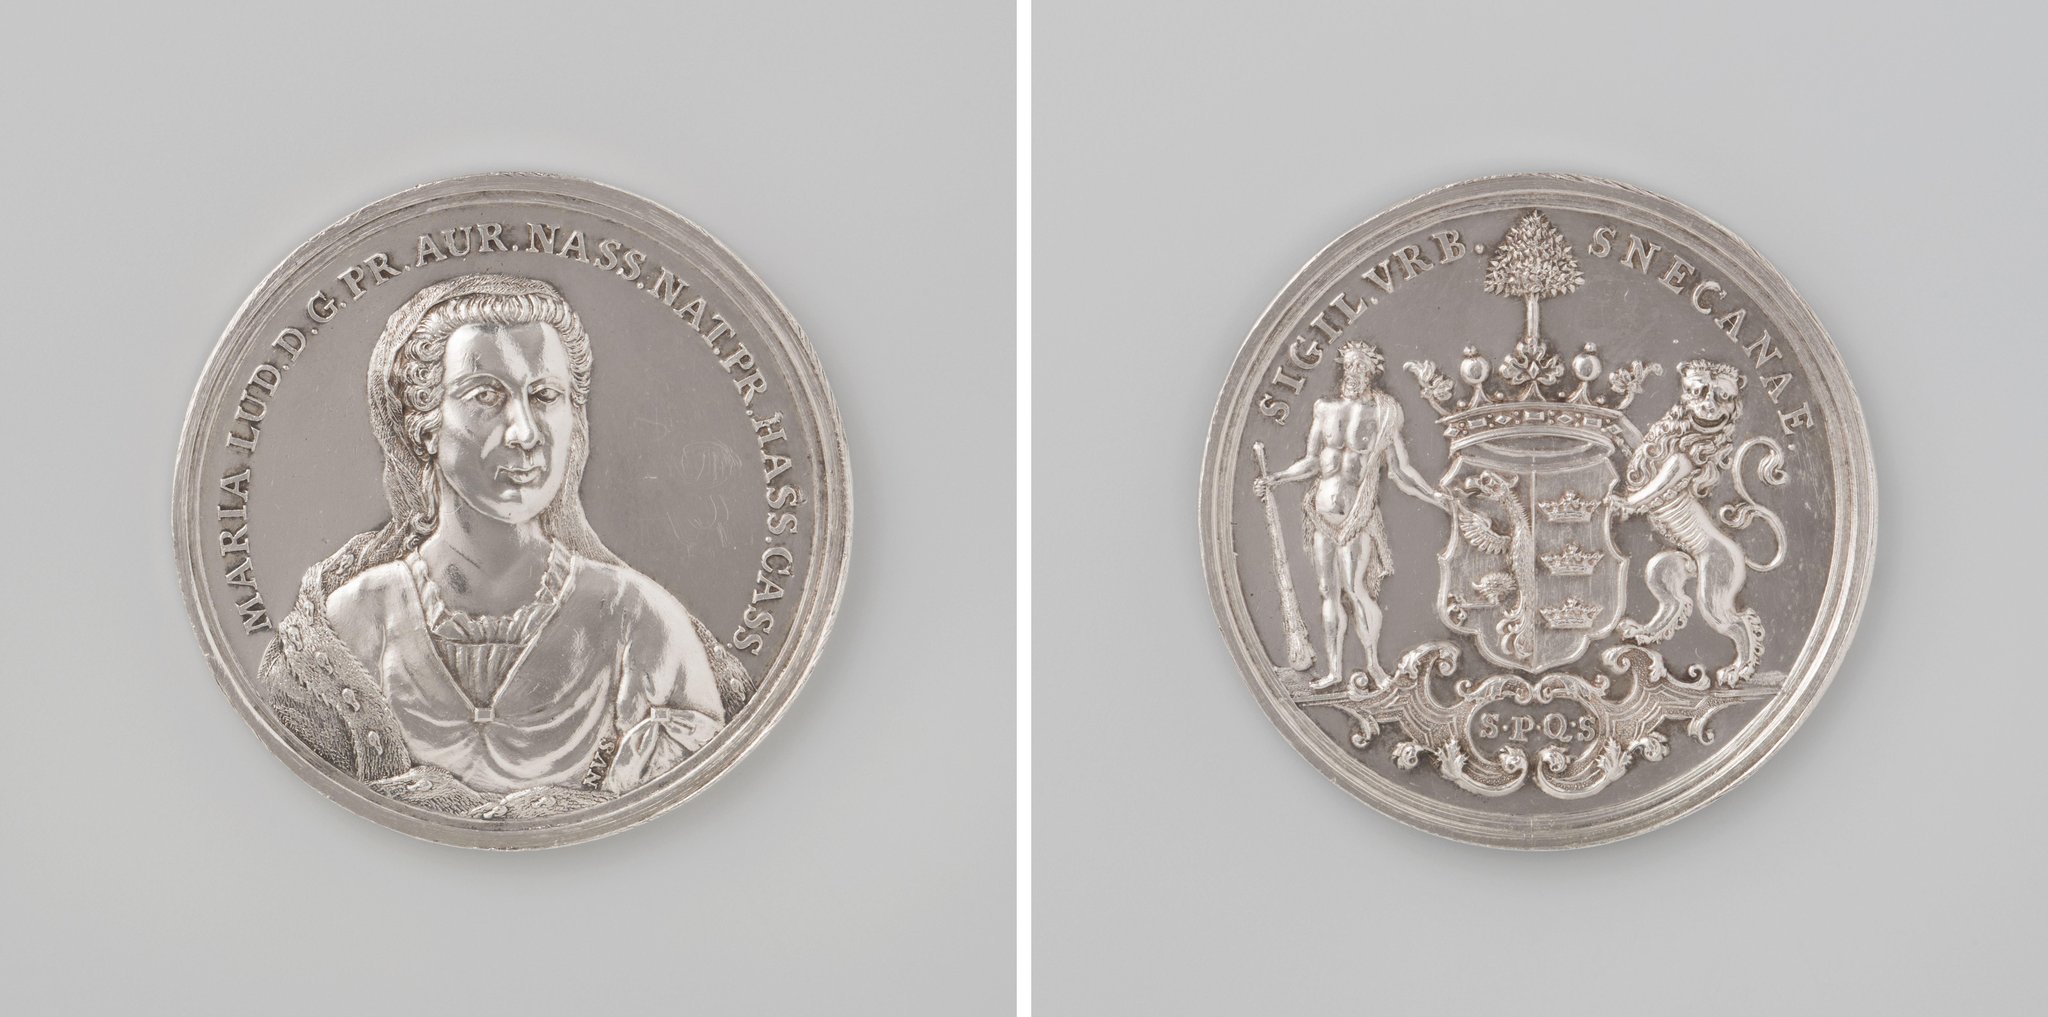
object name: honorary medal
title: Maria Louise, prinses van Oranje-Nassau, penning geslagen op last van de stad Sneek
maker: nicolaas van swinderen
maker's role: jeweler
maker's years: 1705-1760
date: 1759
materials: silver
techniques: striking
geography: the hague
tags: kassel, leeuwarden, maria louisa van hessen-kassel, sneek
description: Zilveren penning. Voorzijde: borststuk vrouw met weduwesluier binnen omschrift. Keerzijde: gekroond wapenschild, bekroond door een oranjeboom, geflankeerd door Herkules met knots en leeuwehuid en een leeuw boven cartouche met opschrift